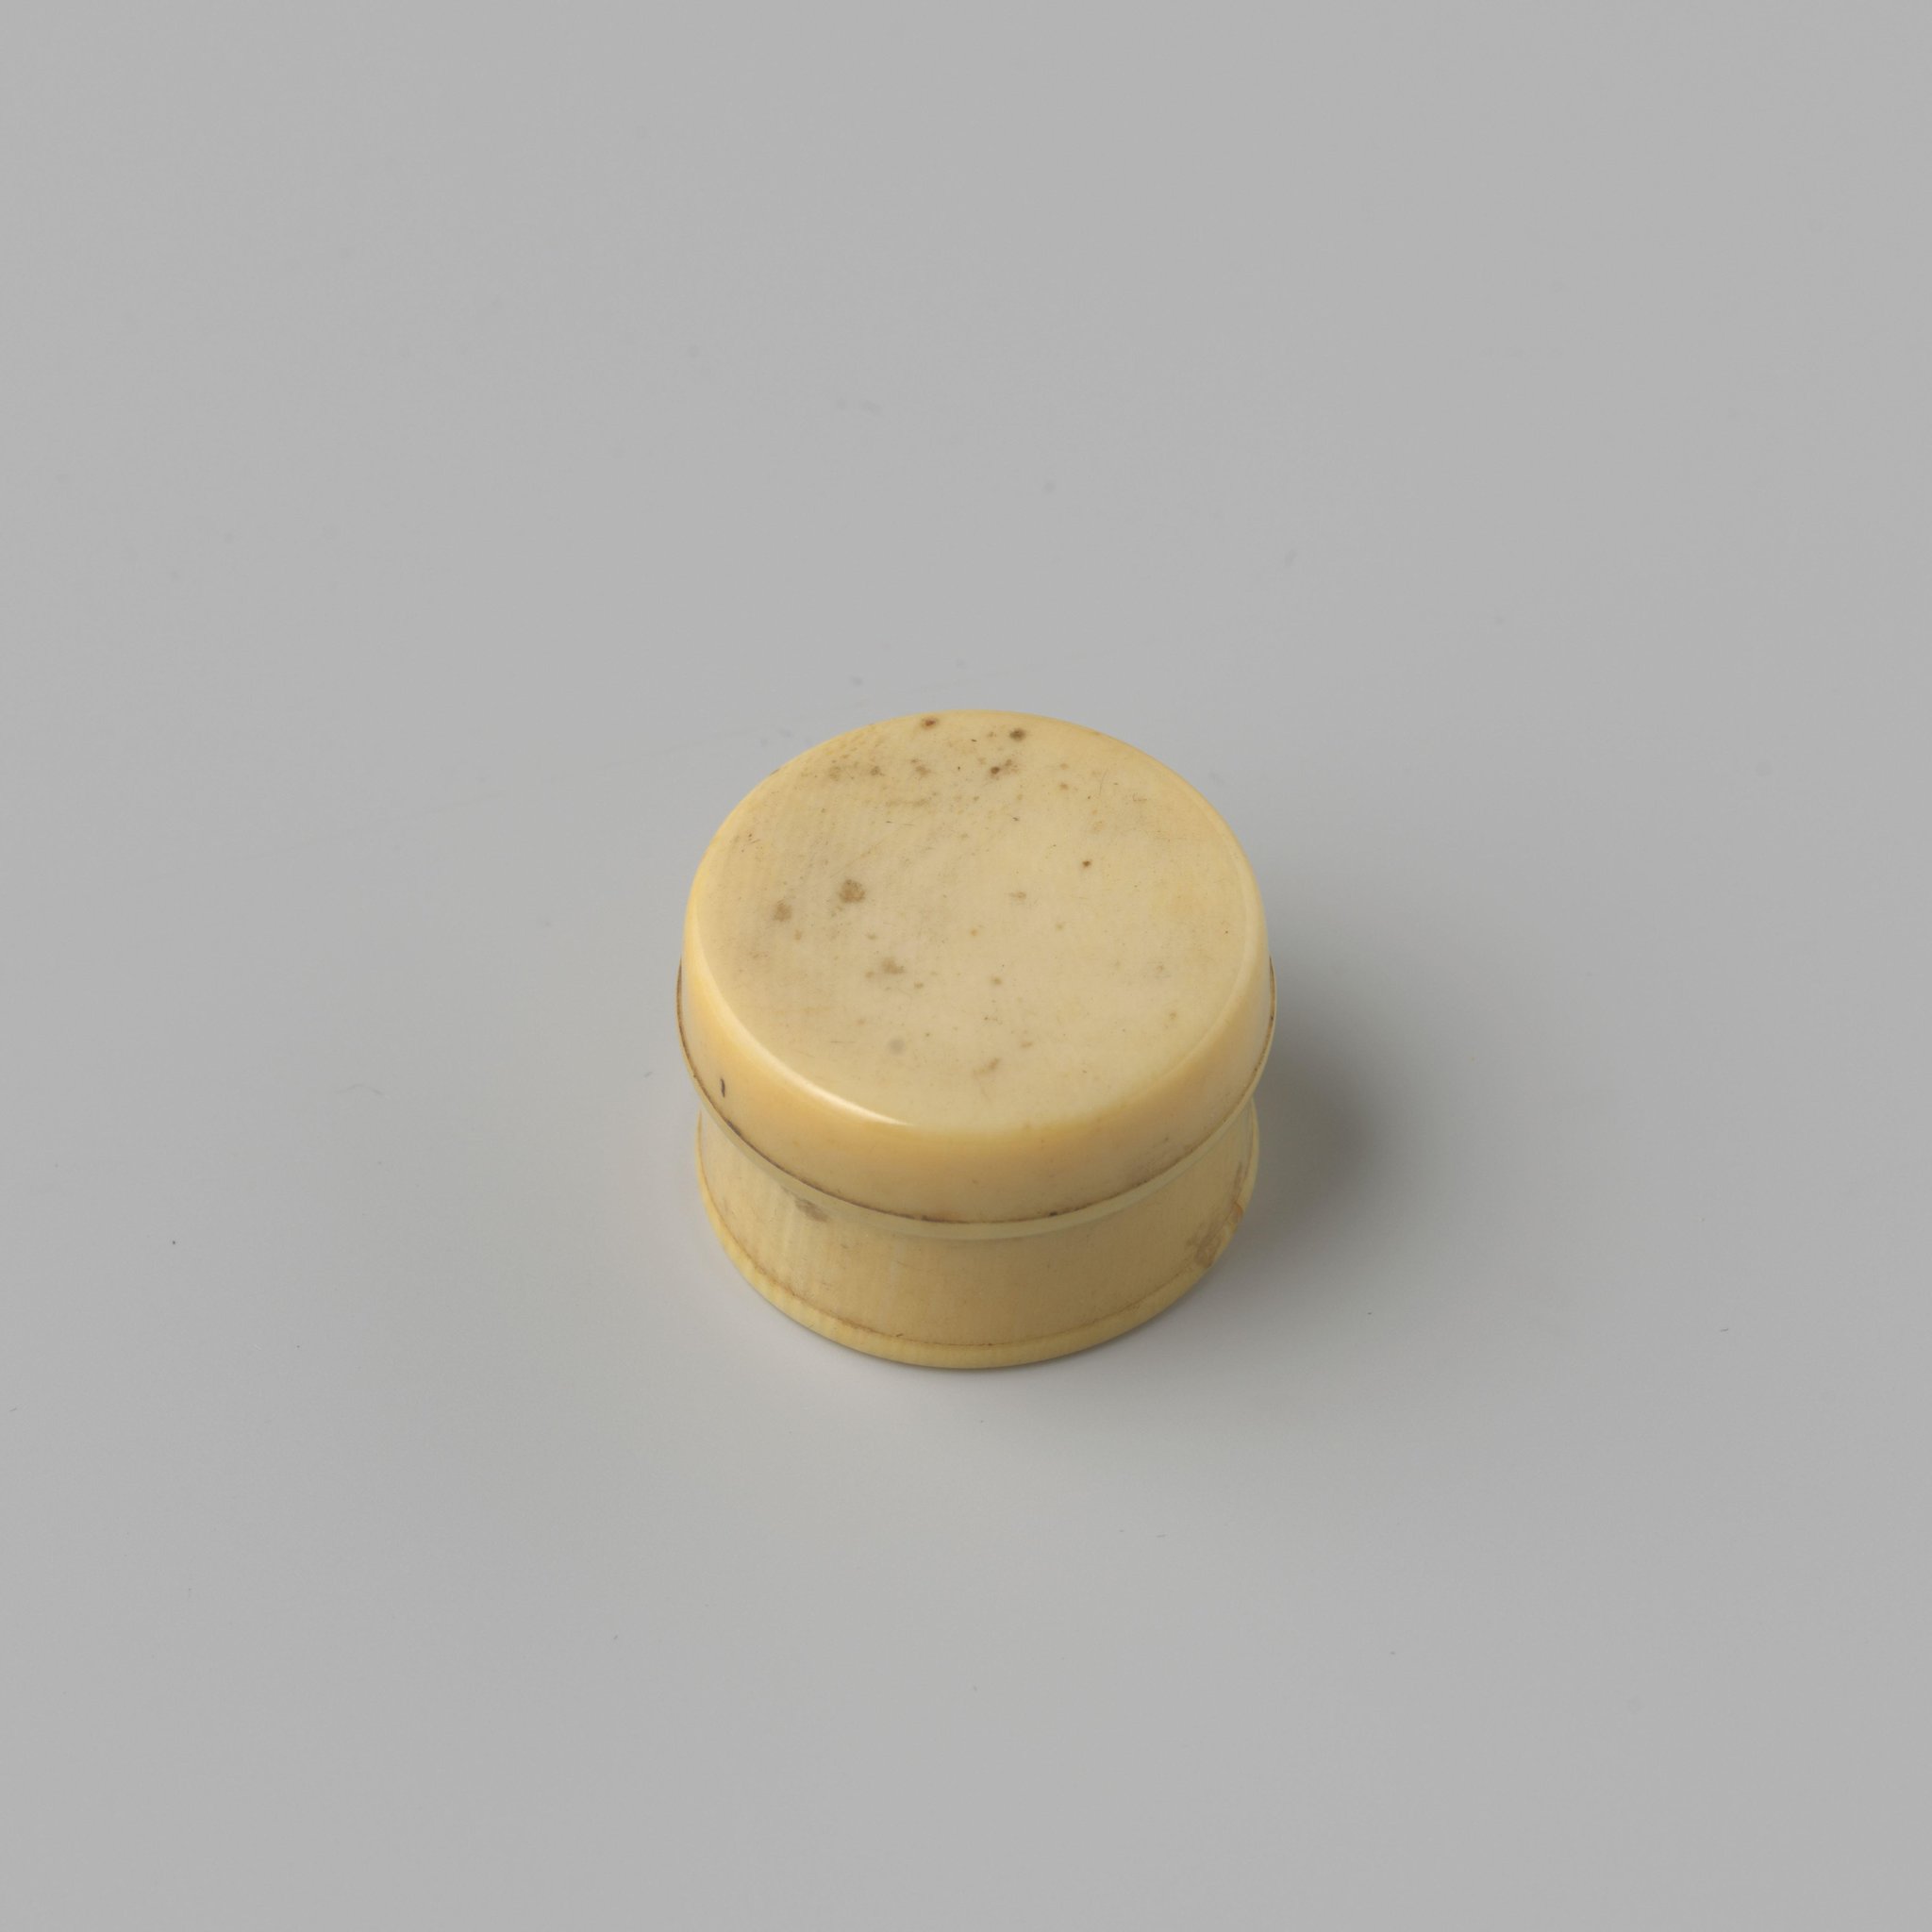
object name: history medal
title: Ivoren doosje voor twee Onze Vader miniatuurpenningen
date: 1600-1750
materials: ivory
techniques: turning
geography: germany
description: Klein ivoren cilindrisch doosje en schroefdeksel.